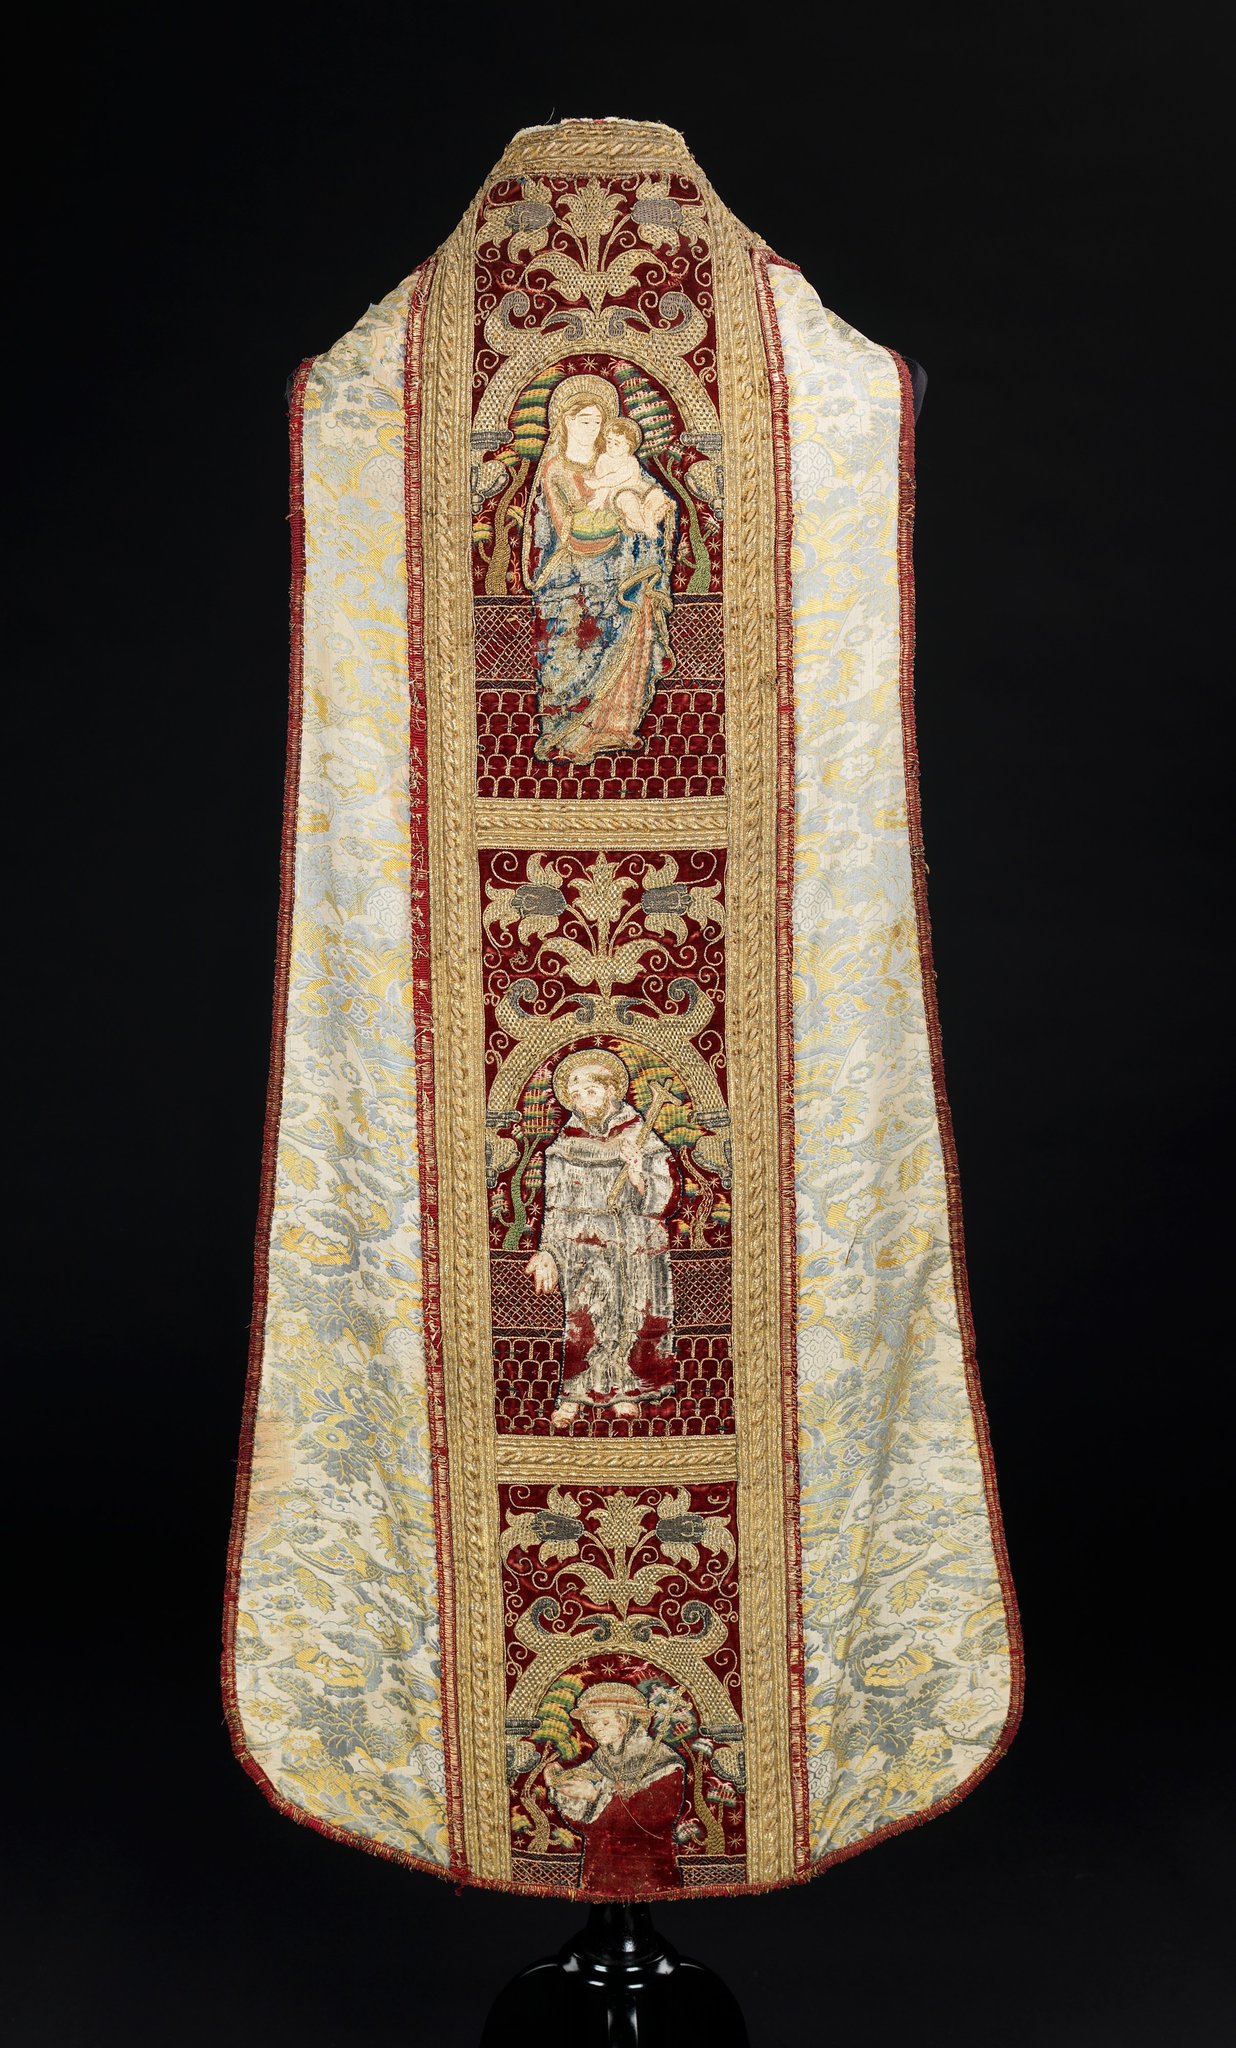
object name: chasuble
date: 1601-1700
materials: linen, metal, silk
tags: madonna and child,saints